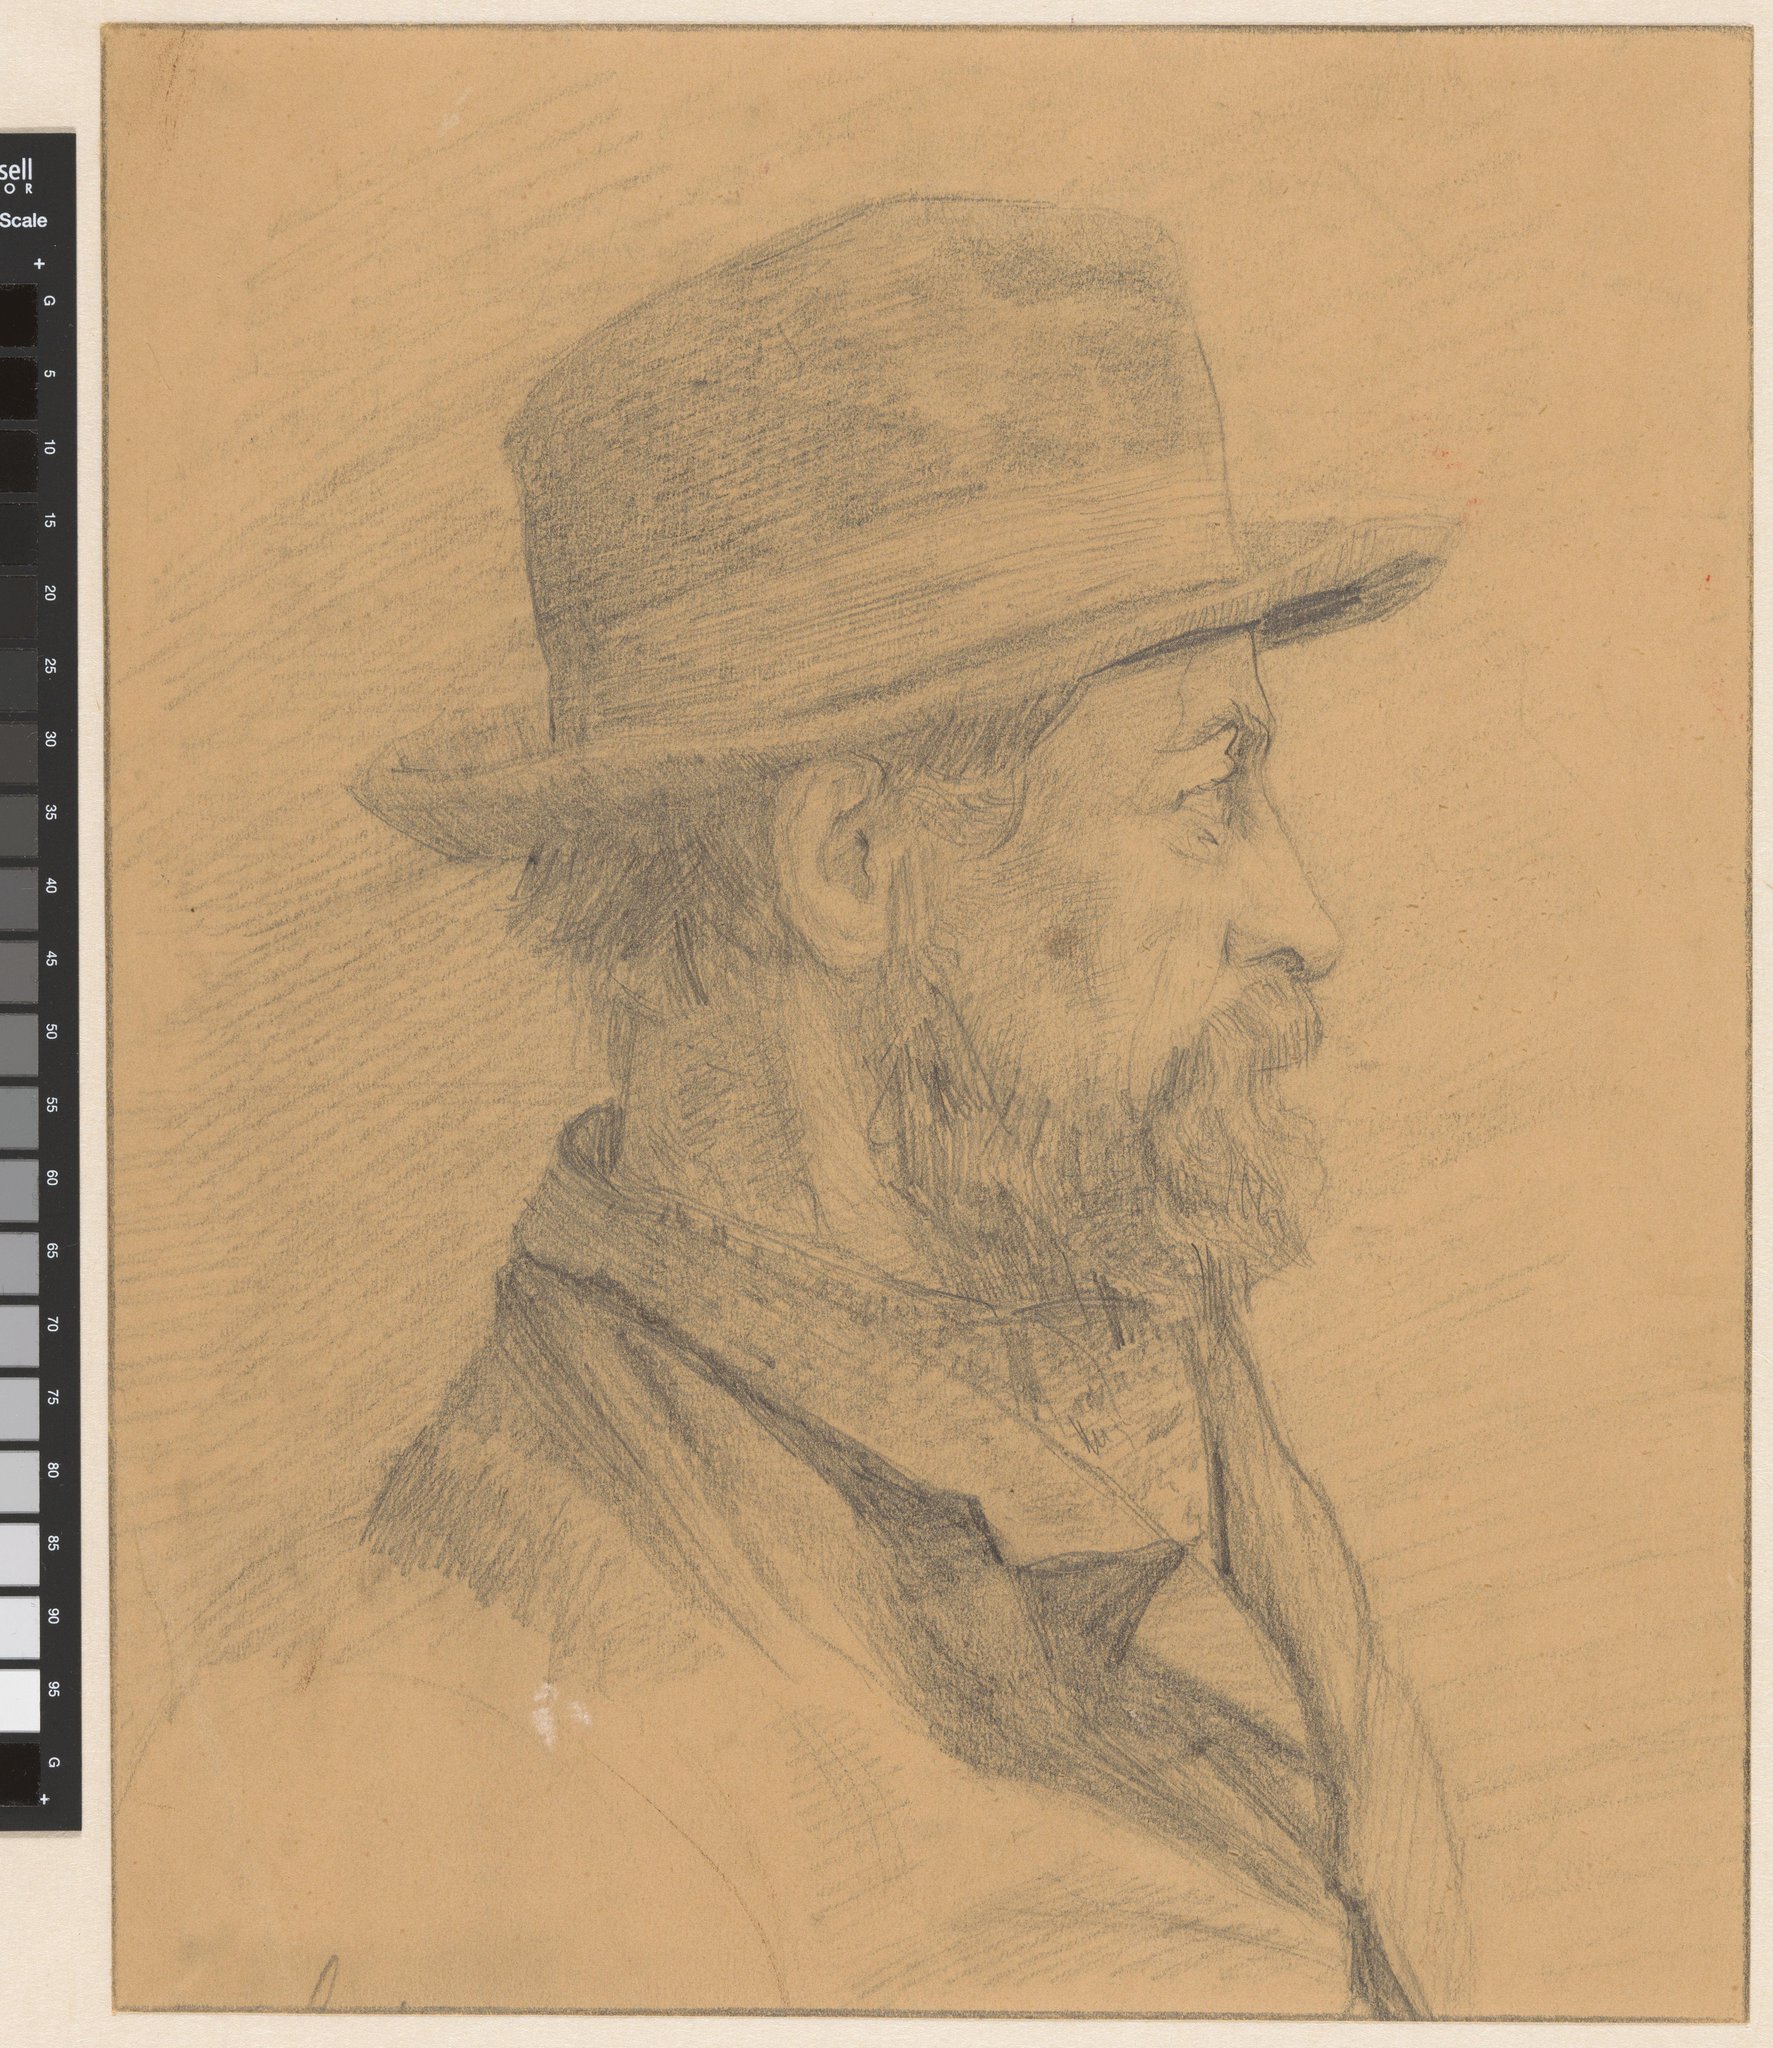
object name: drawing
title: Mansportret met vilthoed, in profiel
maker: Anonymous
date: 1800-1900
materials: paper, pencil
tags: anonymous historical person portrayed alone